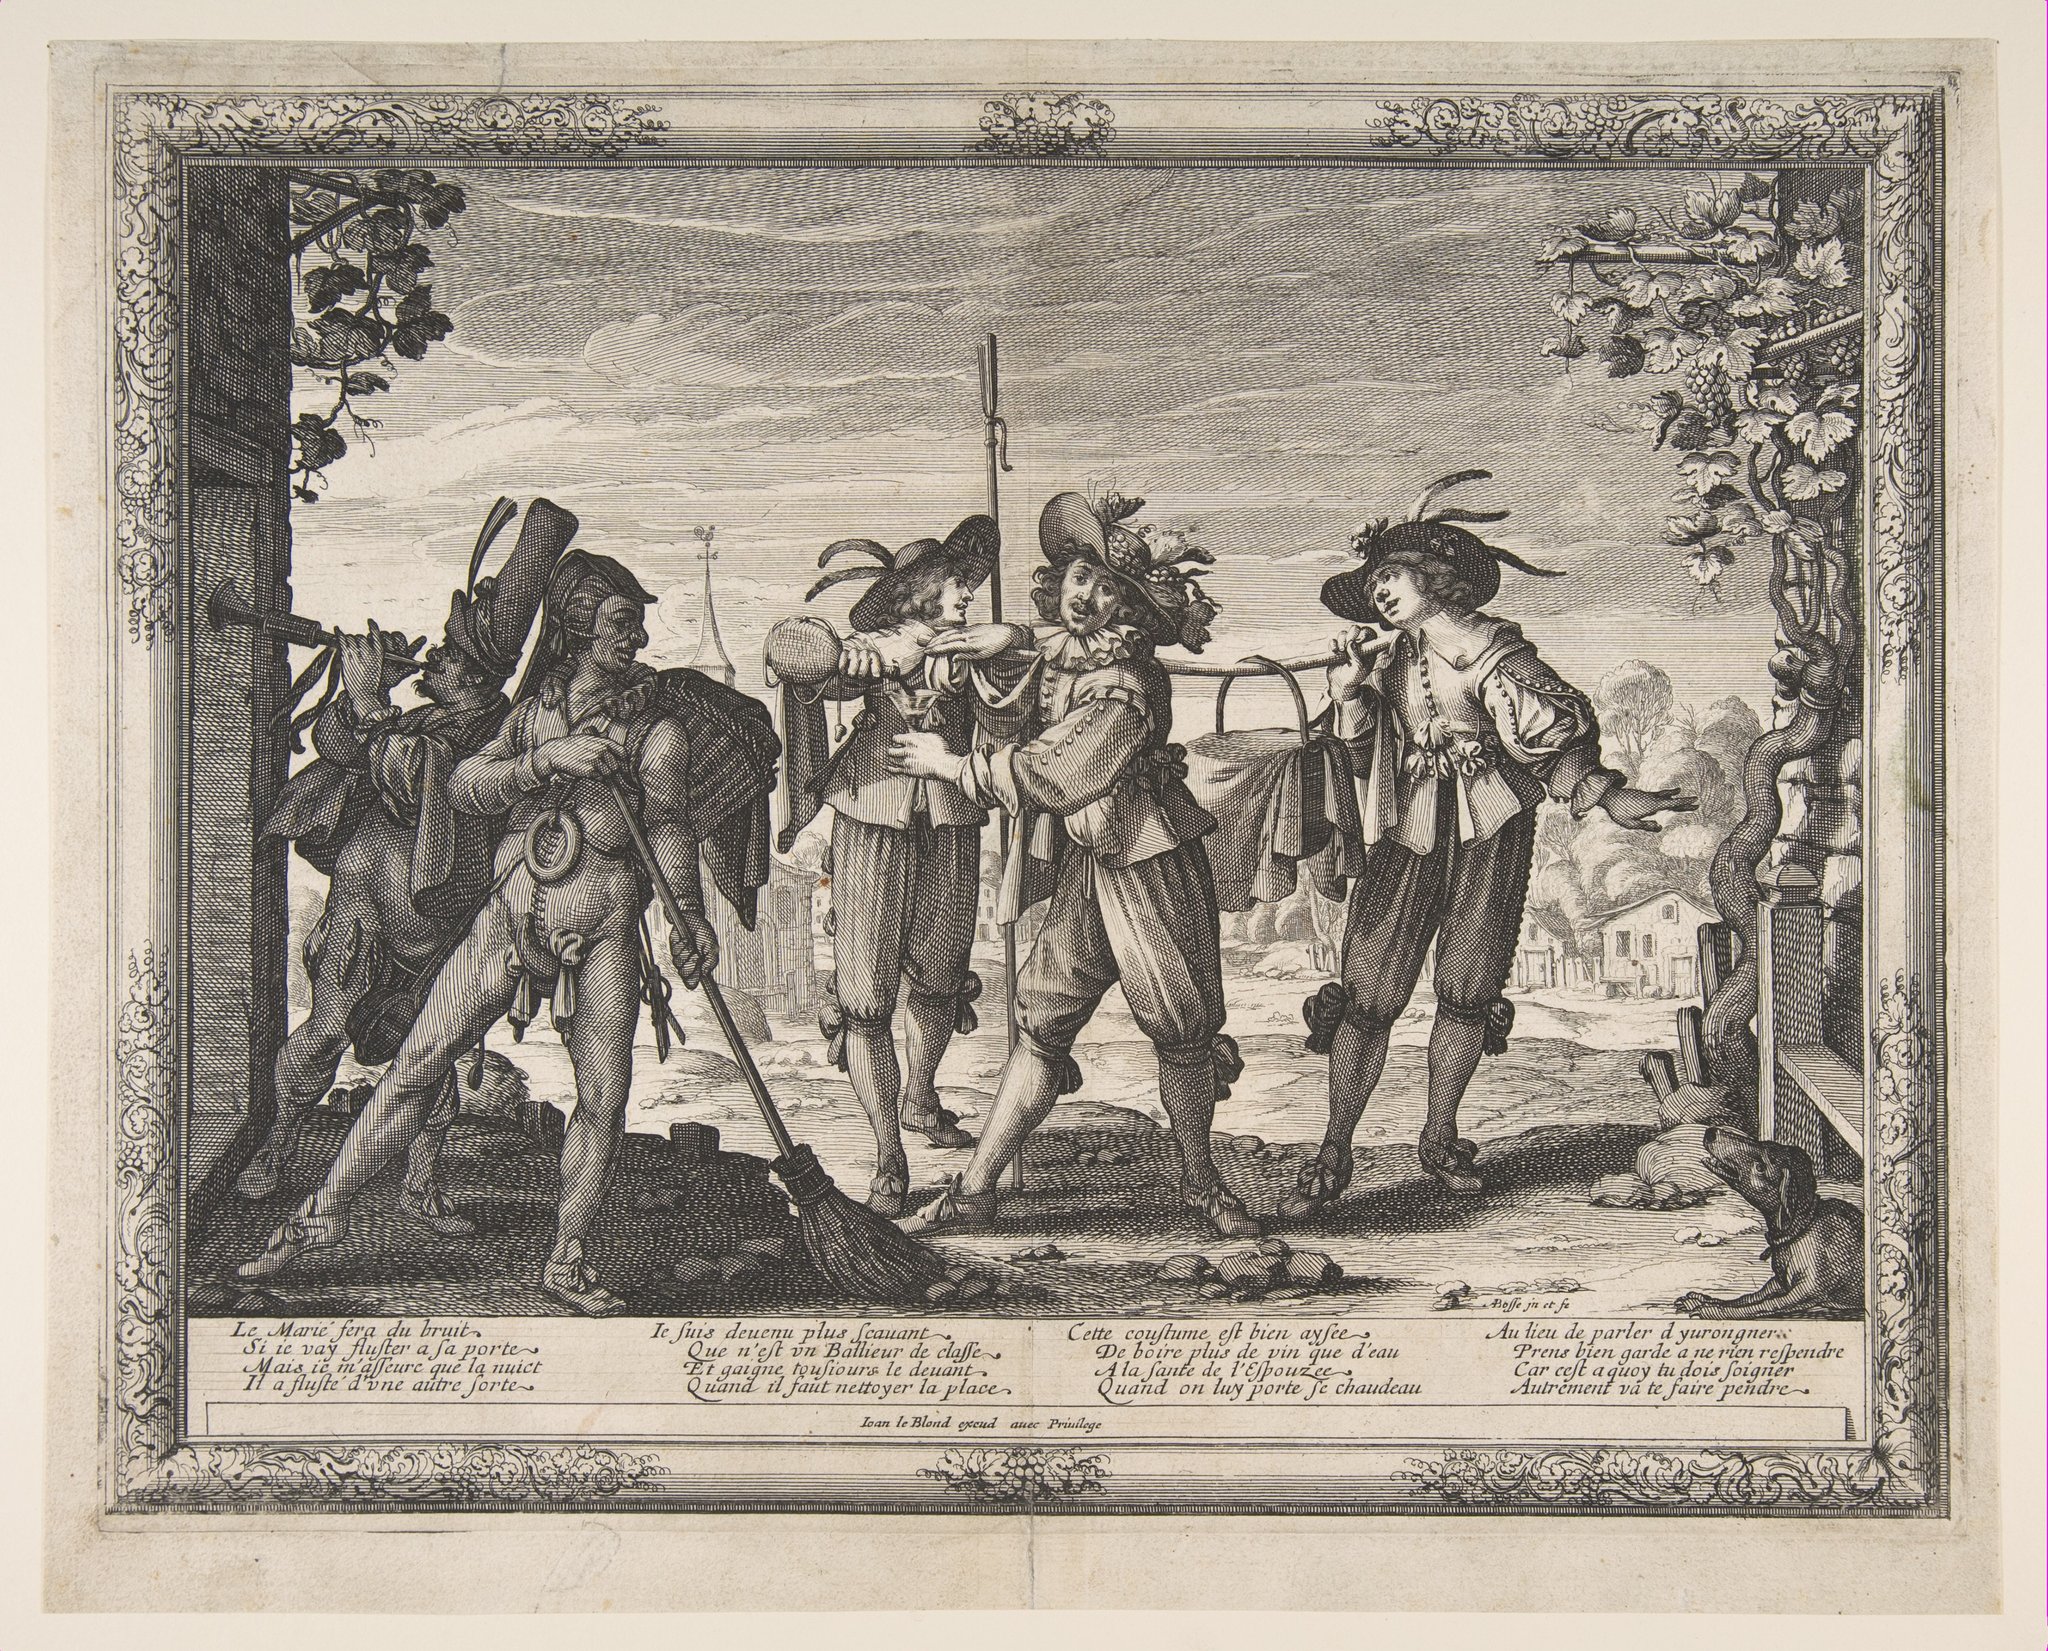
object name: print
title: The Hotpot Carried to the Newlyweds; or The Racket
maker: abraham bosse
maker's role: artist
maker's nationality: french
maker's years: 1602-1676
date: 1633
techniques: engraving, etching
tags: musical instruments,animals,men,working